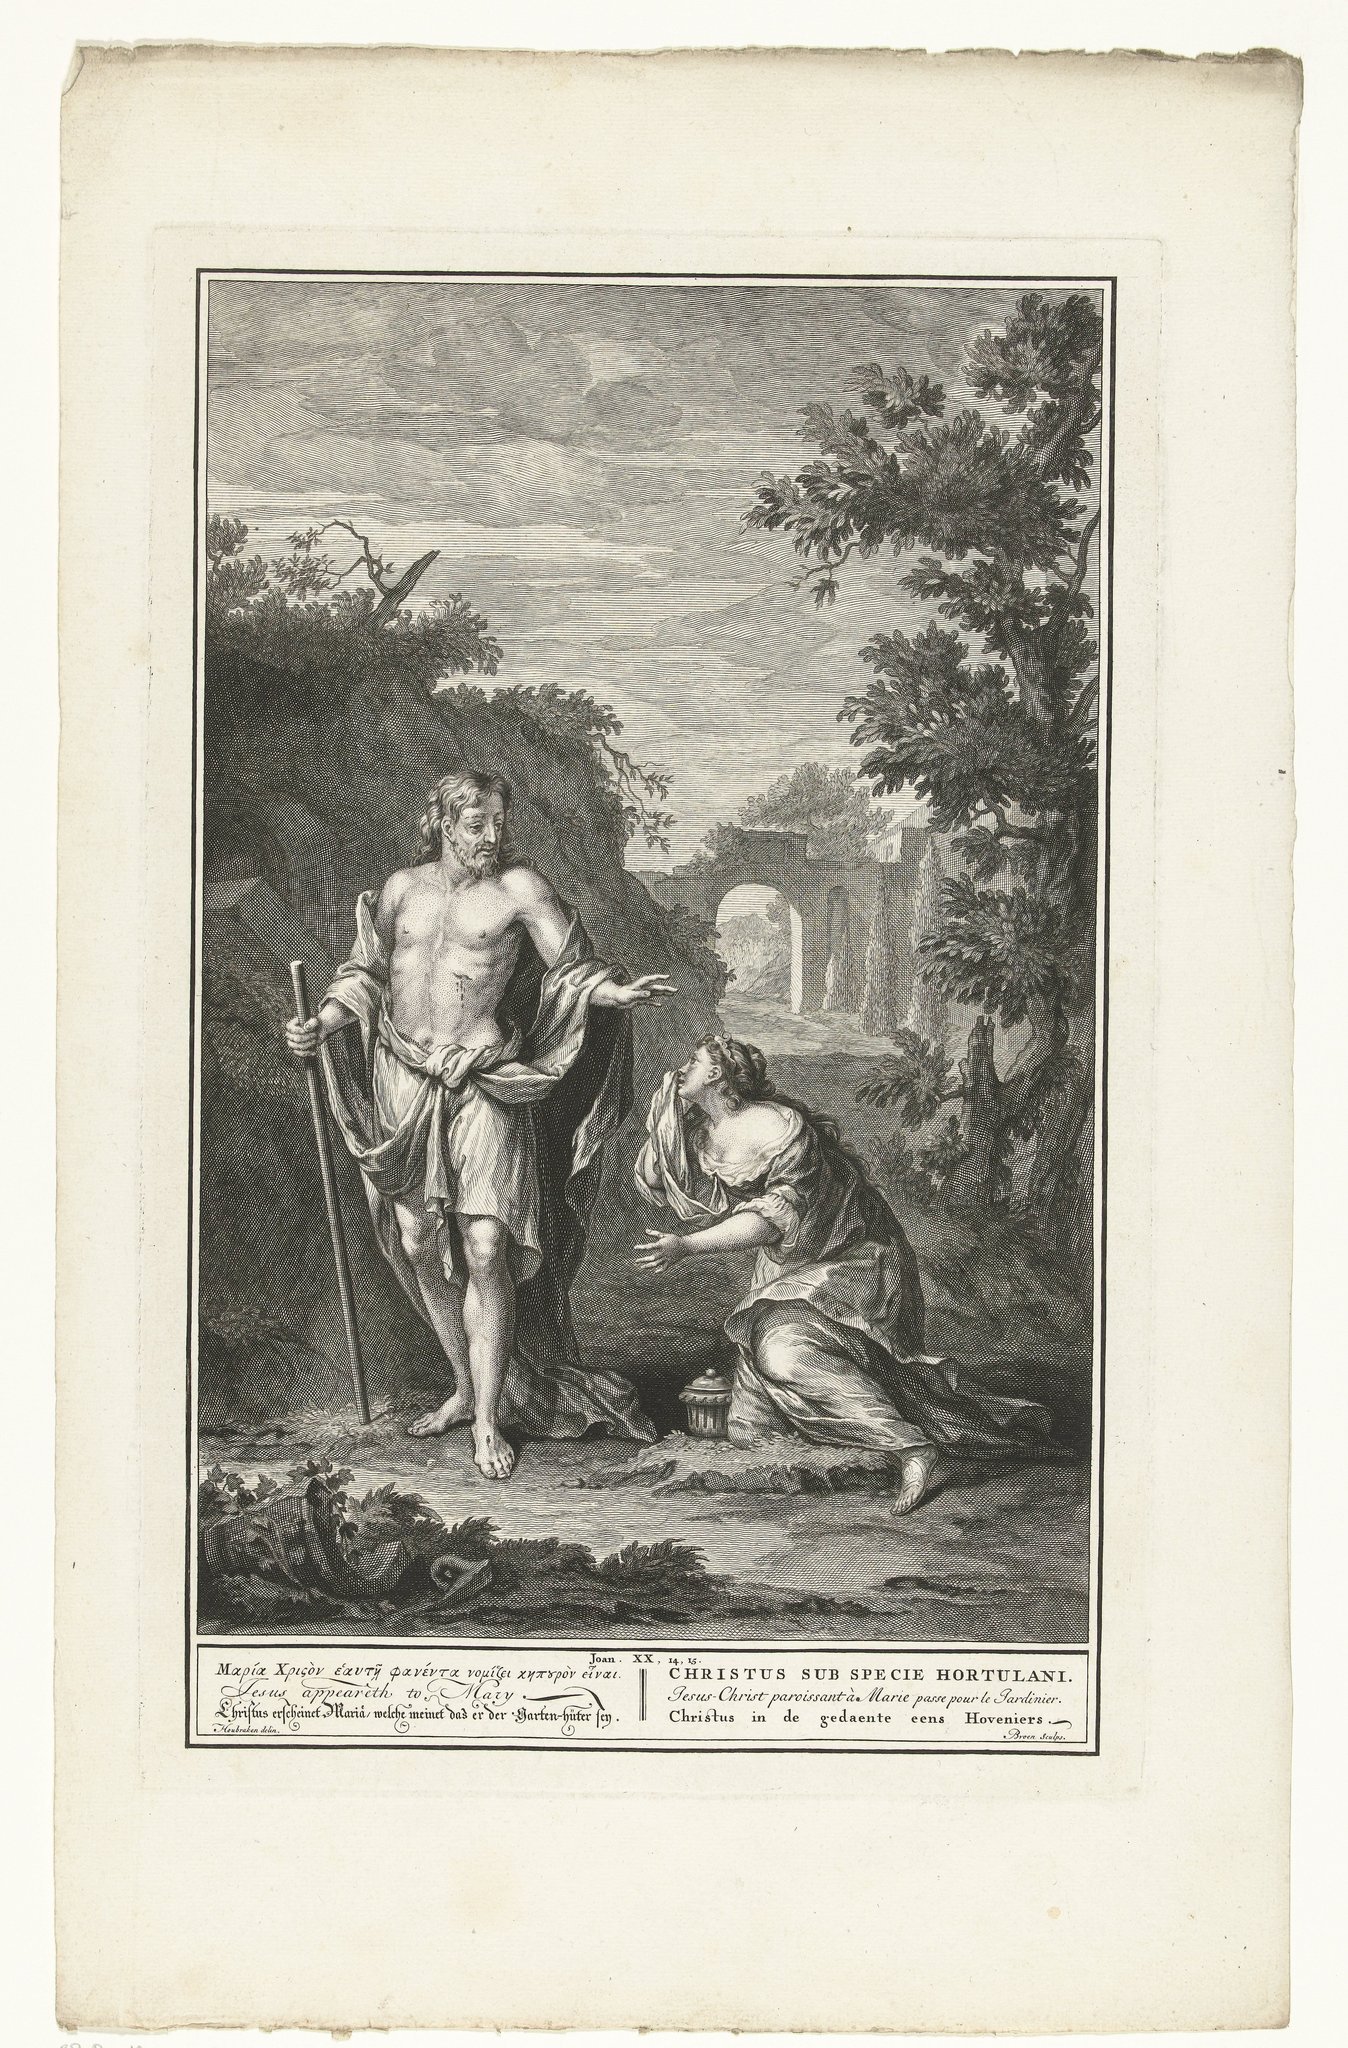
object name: print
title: Christus in de gedaente eens Hoveniers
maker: jacob houbraken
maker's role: draughtsman, print maker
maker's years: 1698-1780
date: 1720-1728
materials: paper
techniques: engraving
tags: mary magdalene kneeling before christ, who is usually represented as a gardener with a hoe and/or a spade; 'noli me tangere'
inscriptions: inscription: ‘Utrechts Fundatie huys’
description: Maria Magdalena knielt voor Christus die met zijn handen aangeeft dat zij hem niet moet aanraken. Illustratie voor het Nieuwe Testament, Joh. 20, 14-15. Onder de voorstelling een titel in het Grieks, Engels, Duits, Latijn, Frans en Nederlands.